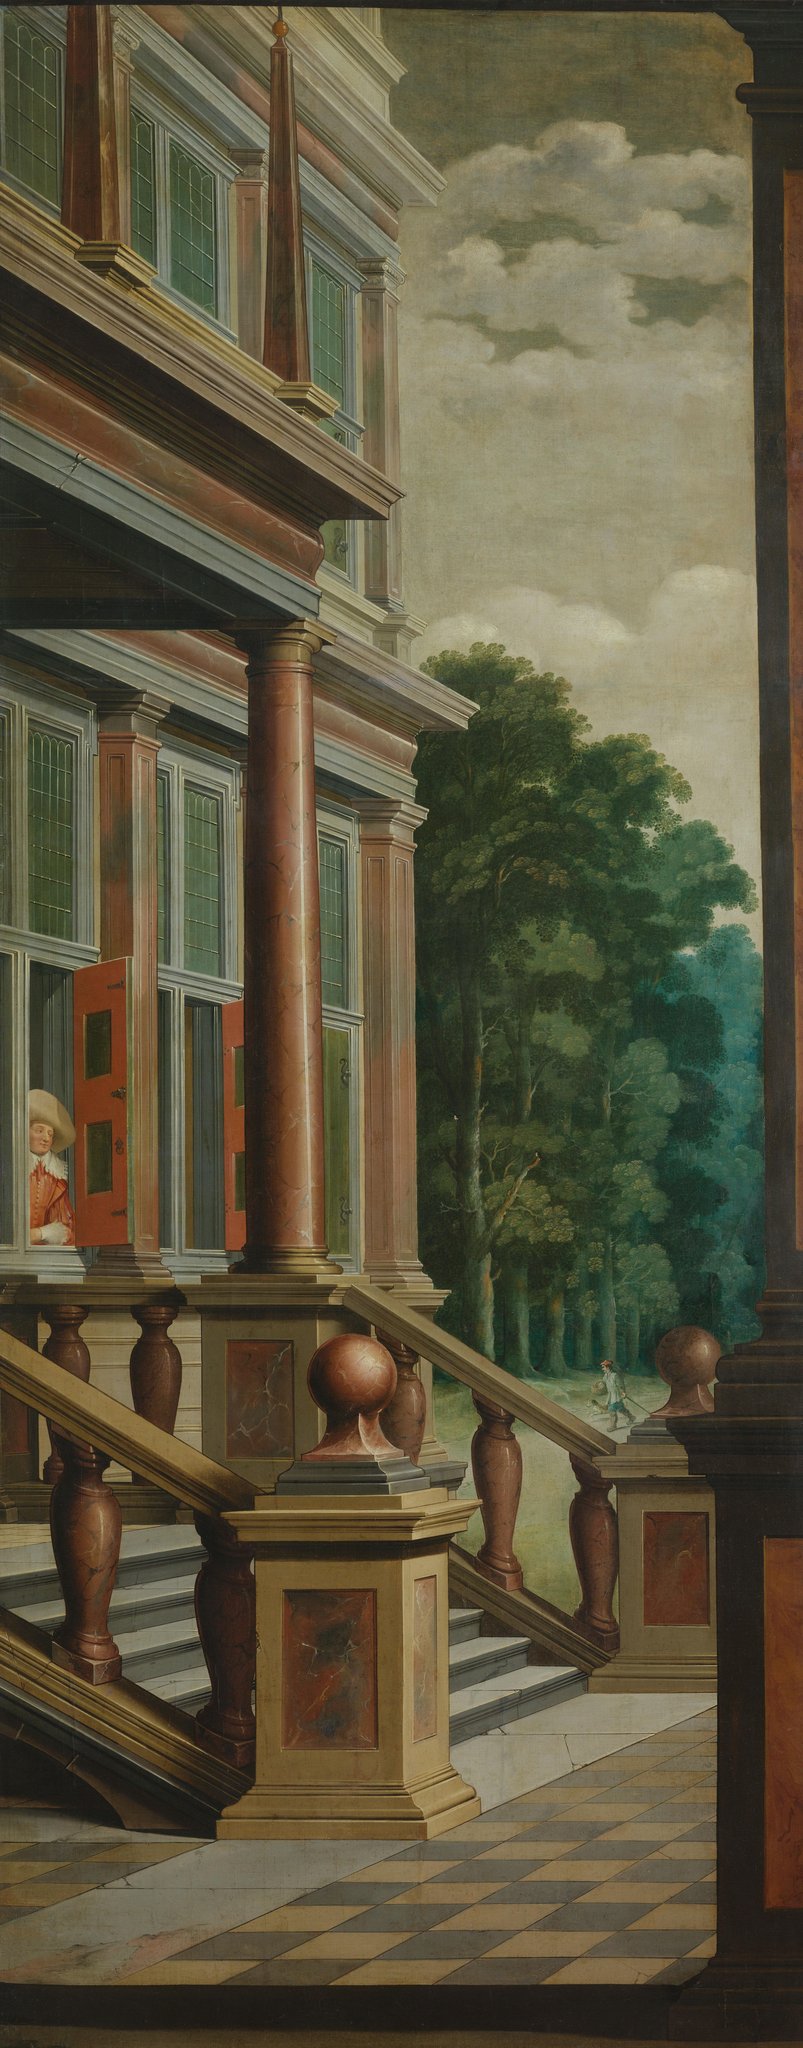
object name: painting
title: A Seven-Part Decorative Sequence: An Outdoor Stairway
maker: dirck van delen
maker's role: painter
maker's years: 1604-1671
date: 1630-1632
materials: canvas, oil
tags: palace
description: Onderdeel van een zevendelige kamerbeschildering in vijf stukken met afbeeldingen van een interieur, twee galerijen en twee buitentrappen, bevolkt met talrijke personen. Het betreft hier de rechterhelft van de voorstelling van een buitentrap. (Zie voor de andere helft SK-A-3940)